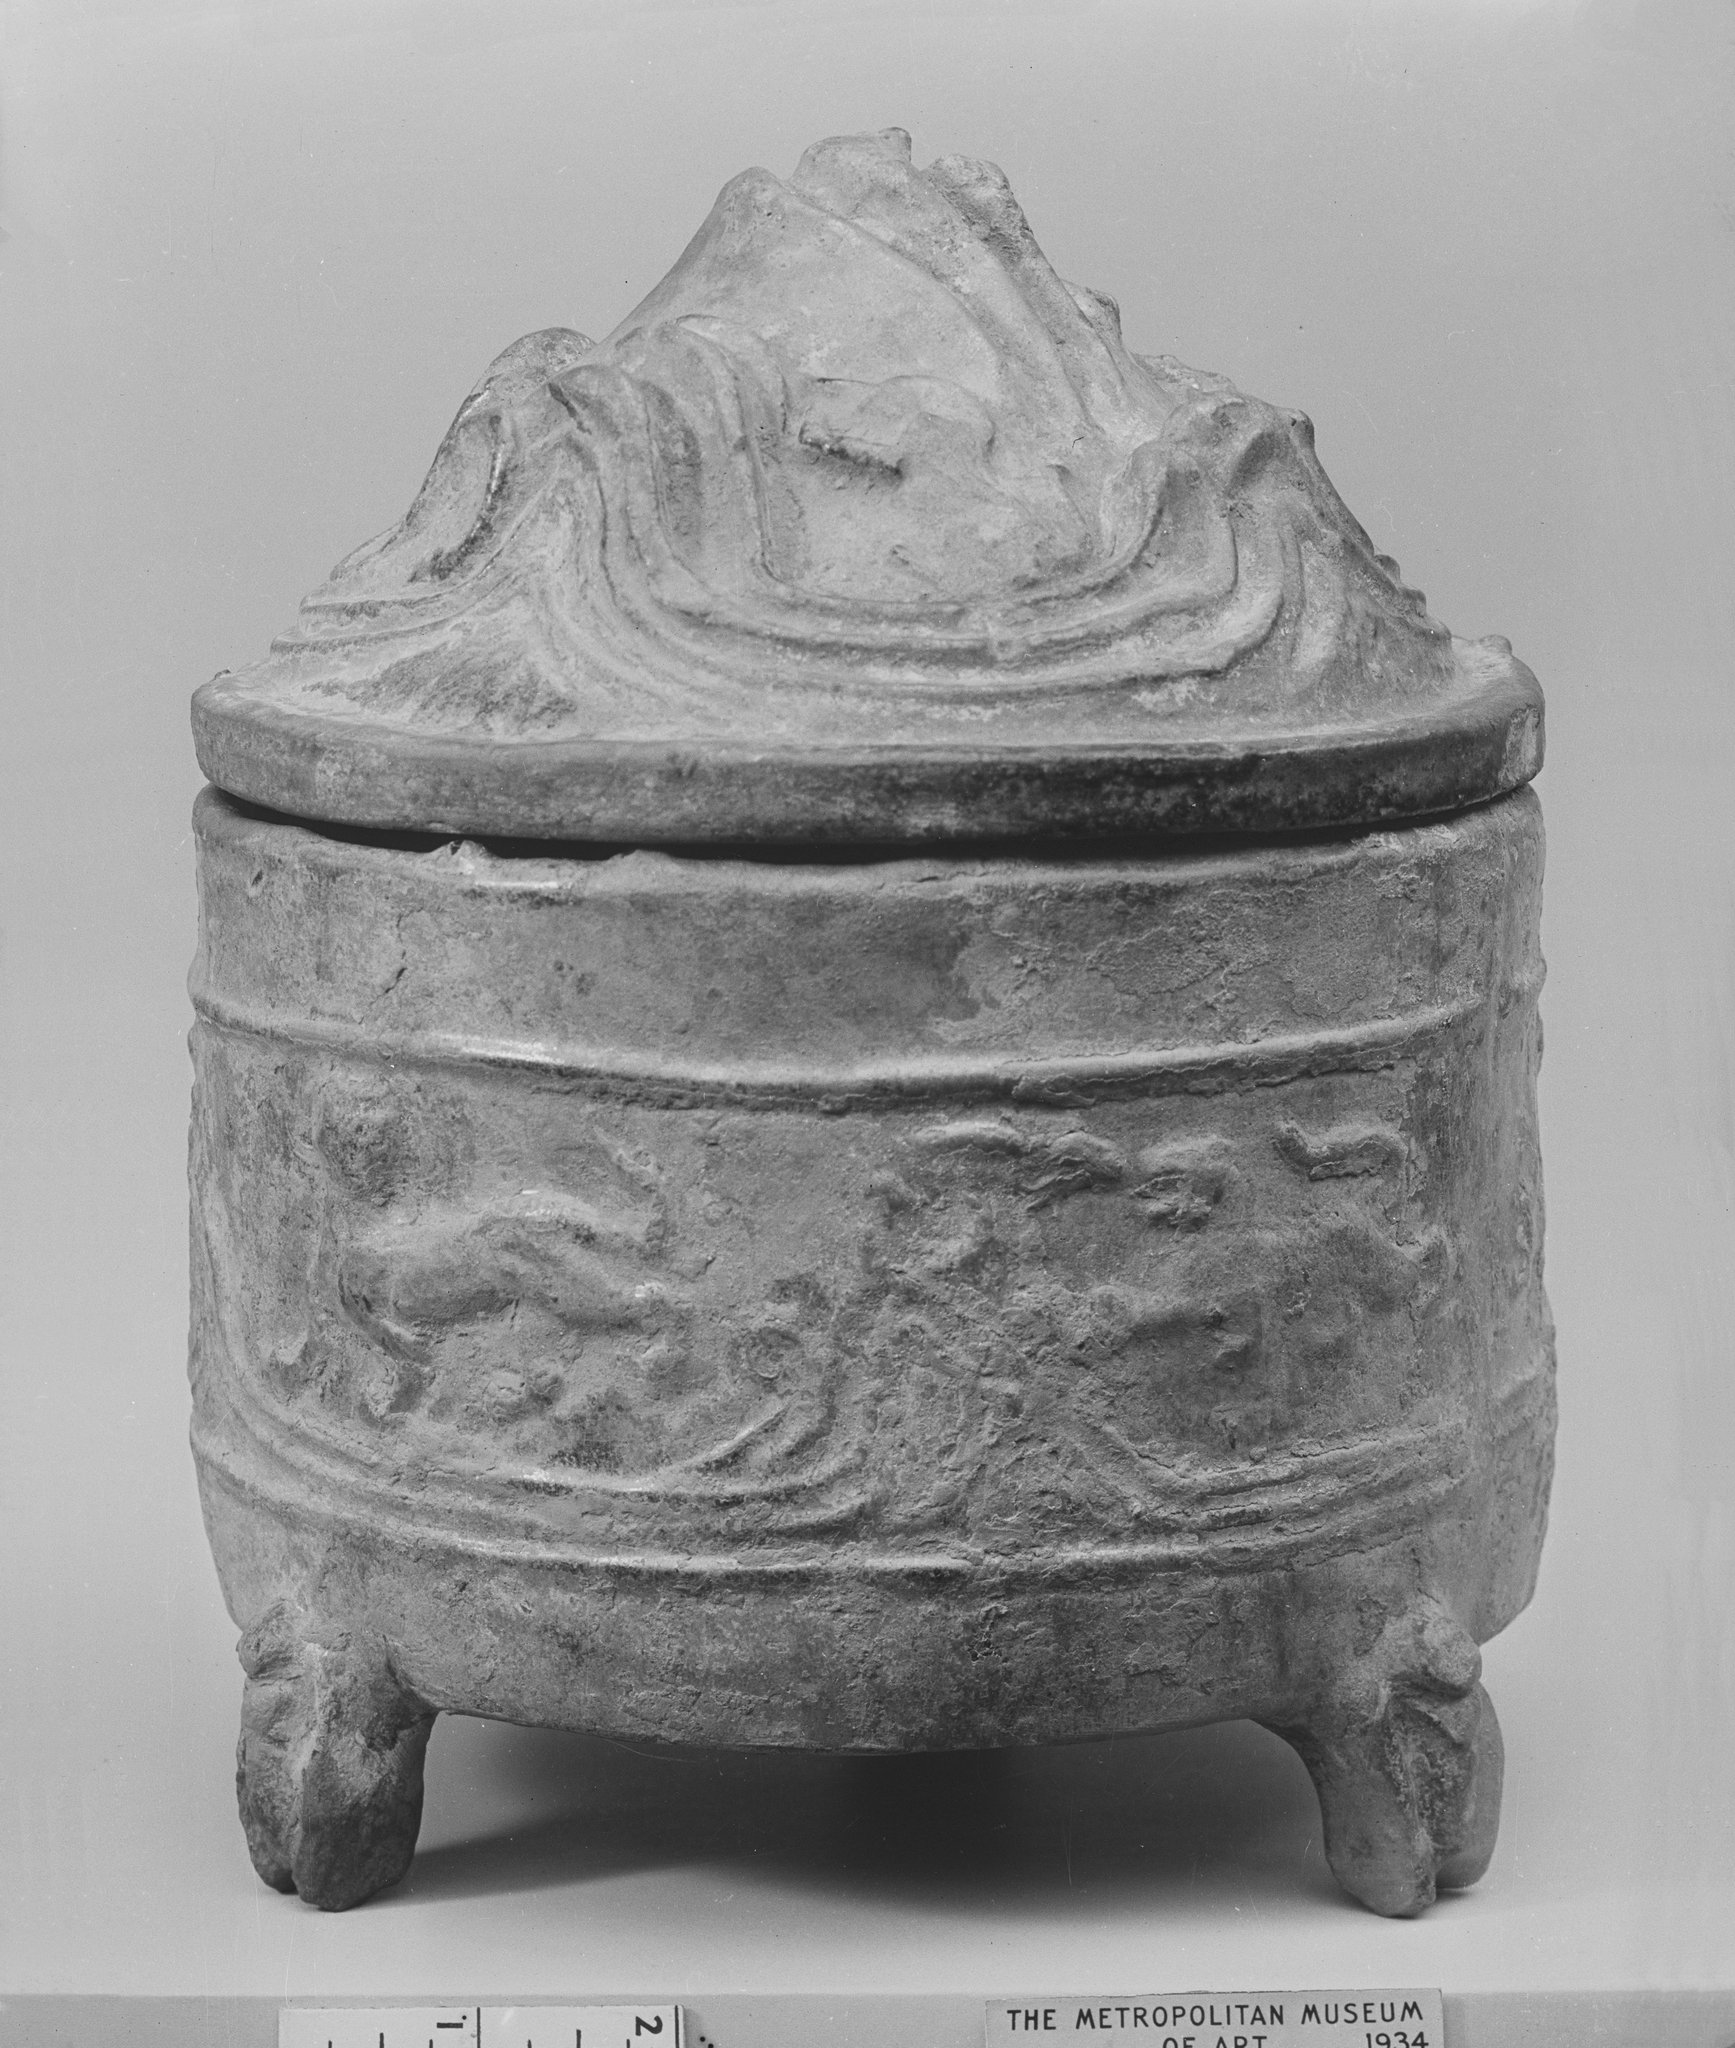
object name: jar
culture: chinese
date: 206 BCE-220 CE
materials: ceramic, glaze